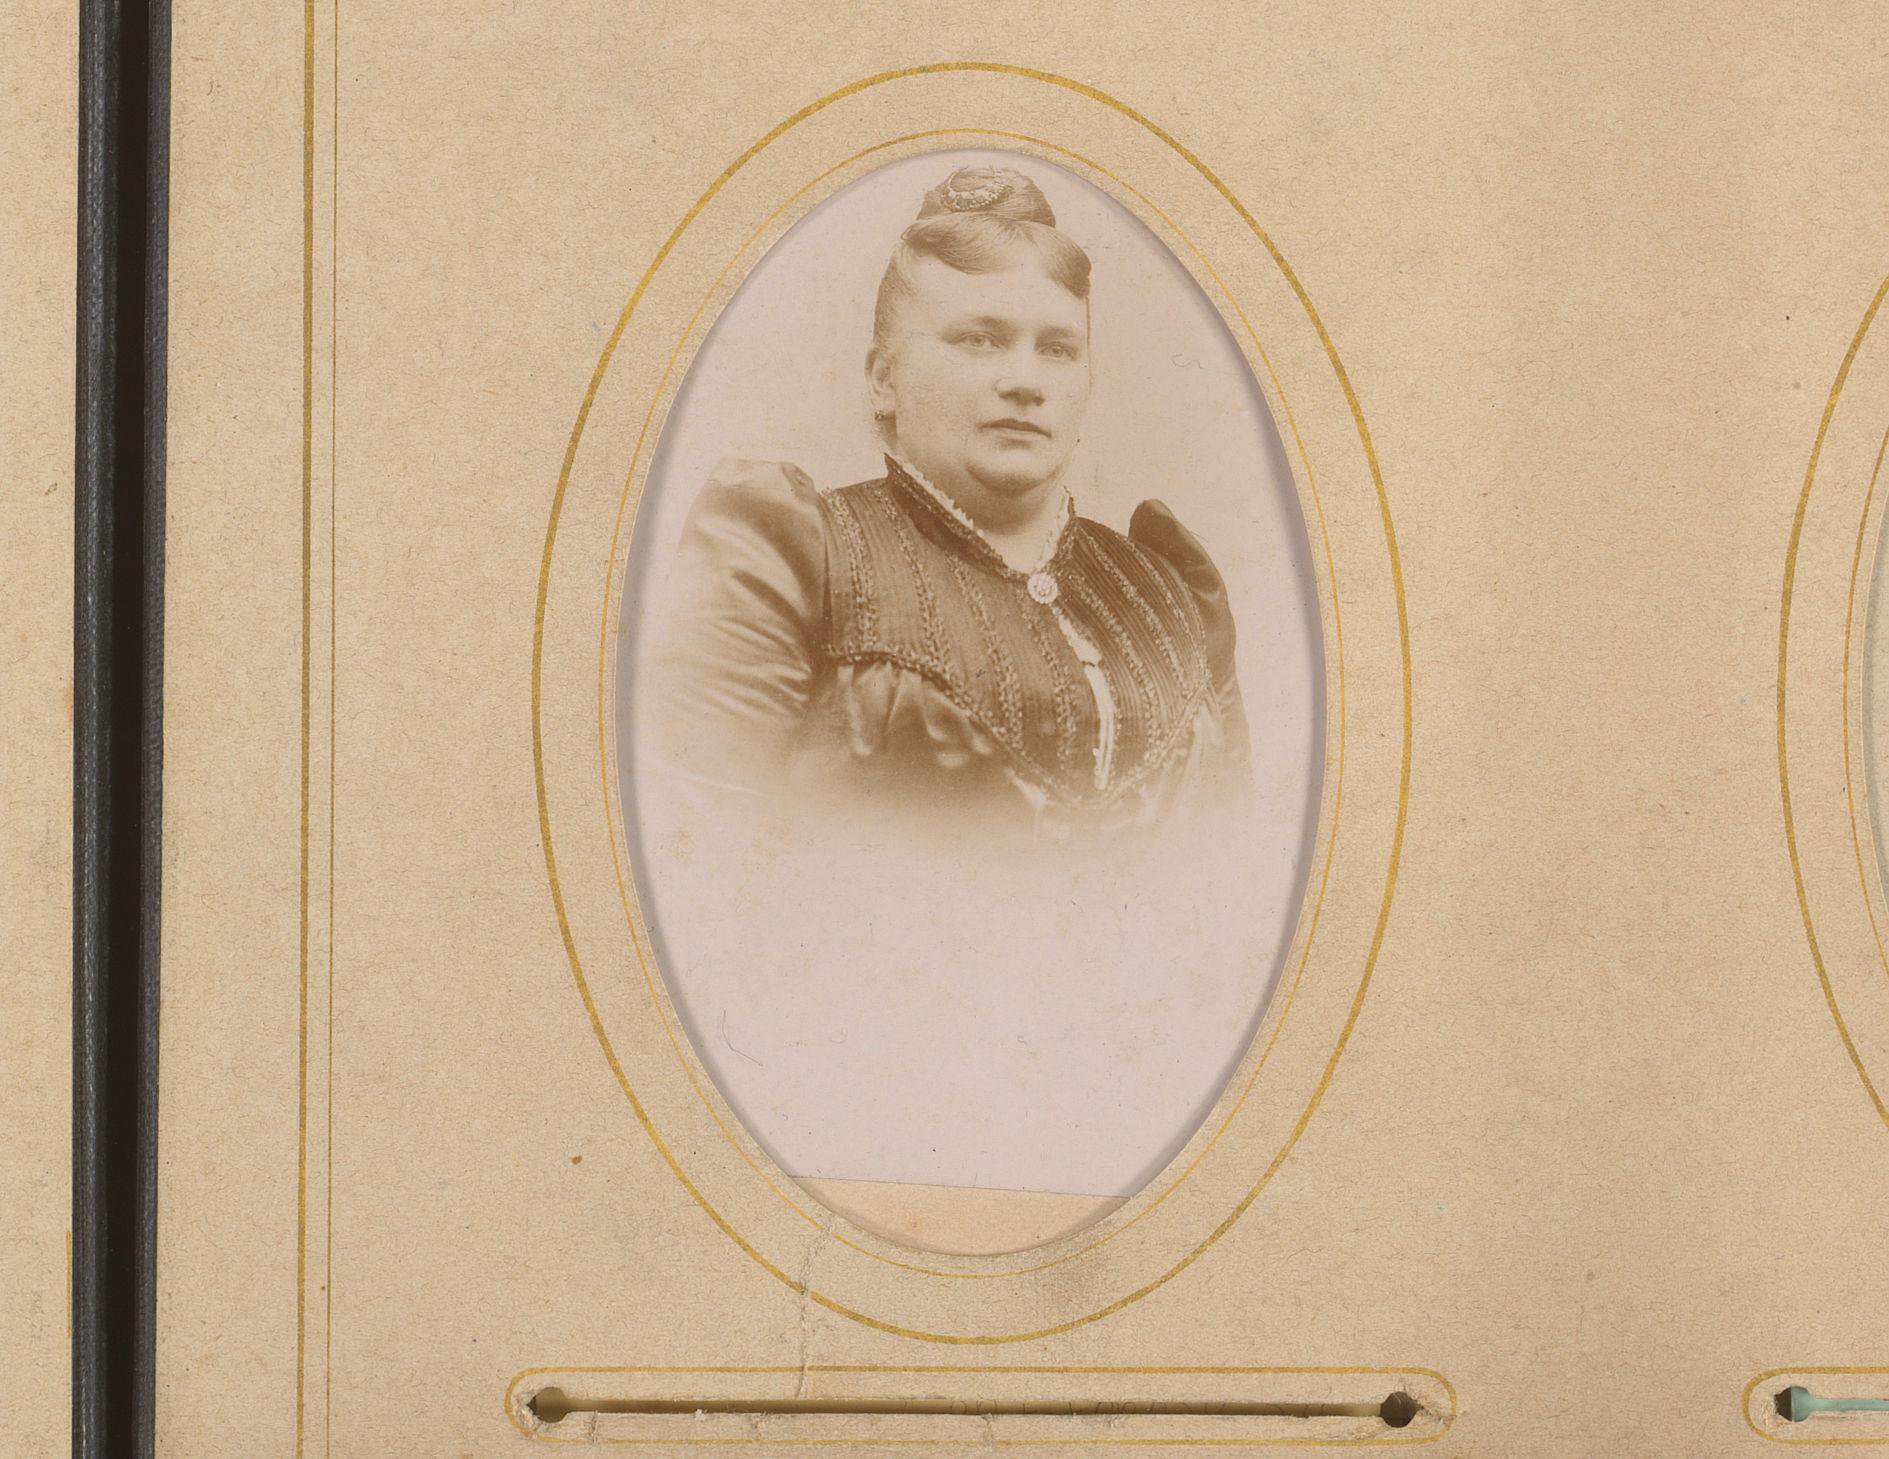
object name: carte de visite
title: Portret van een vrouw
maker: fr. john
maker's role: fotograaf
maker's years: 1849-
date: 1860-1900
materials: cardboard, photographic support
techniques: collodion silver print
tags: adult woman, historical persons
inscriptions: inscription: ‘Photographie/ Fr. John/ Canal des Vieus Lions 2 -1/ Anvers/ Les clieches sont consservés/ Prager & Lodja, Berlin.’, name: ‘Fr. John Anvers’